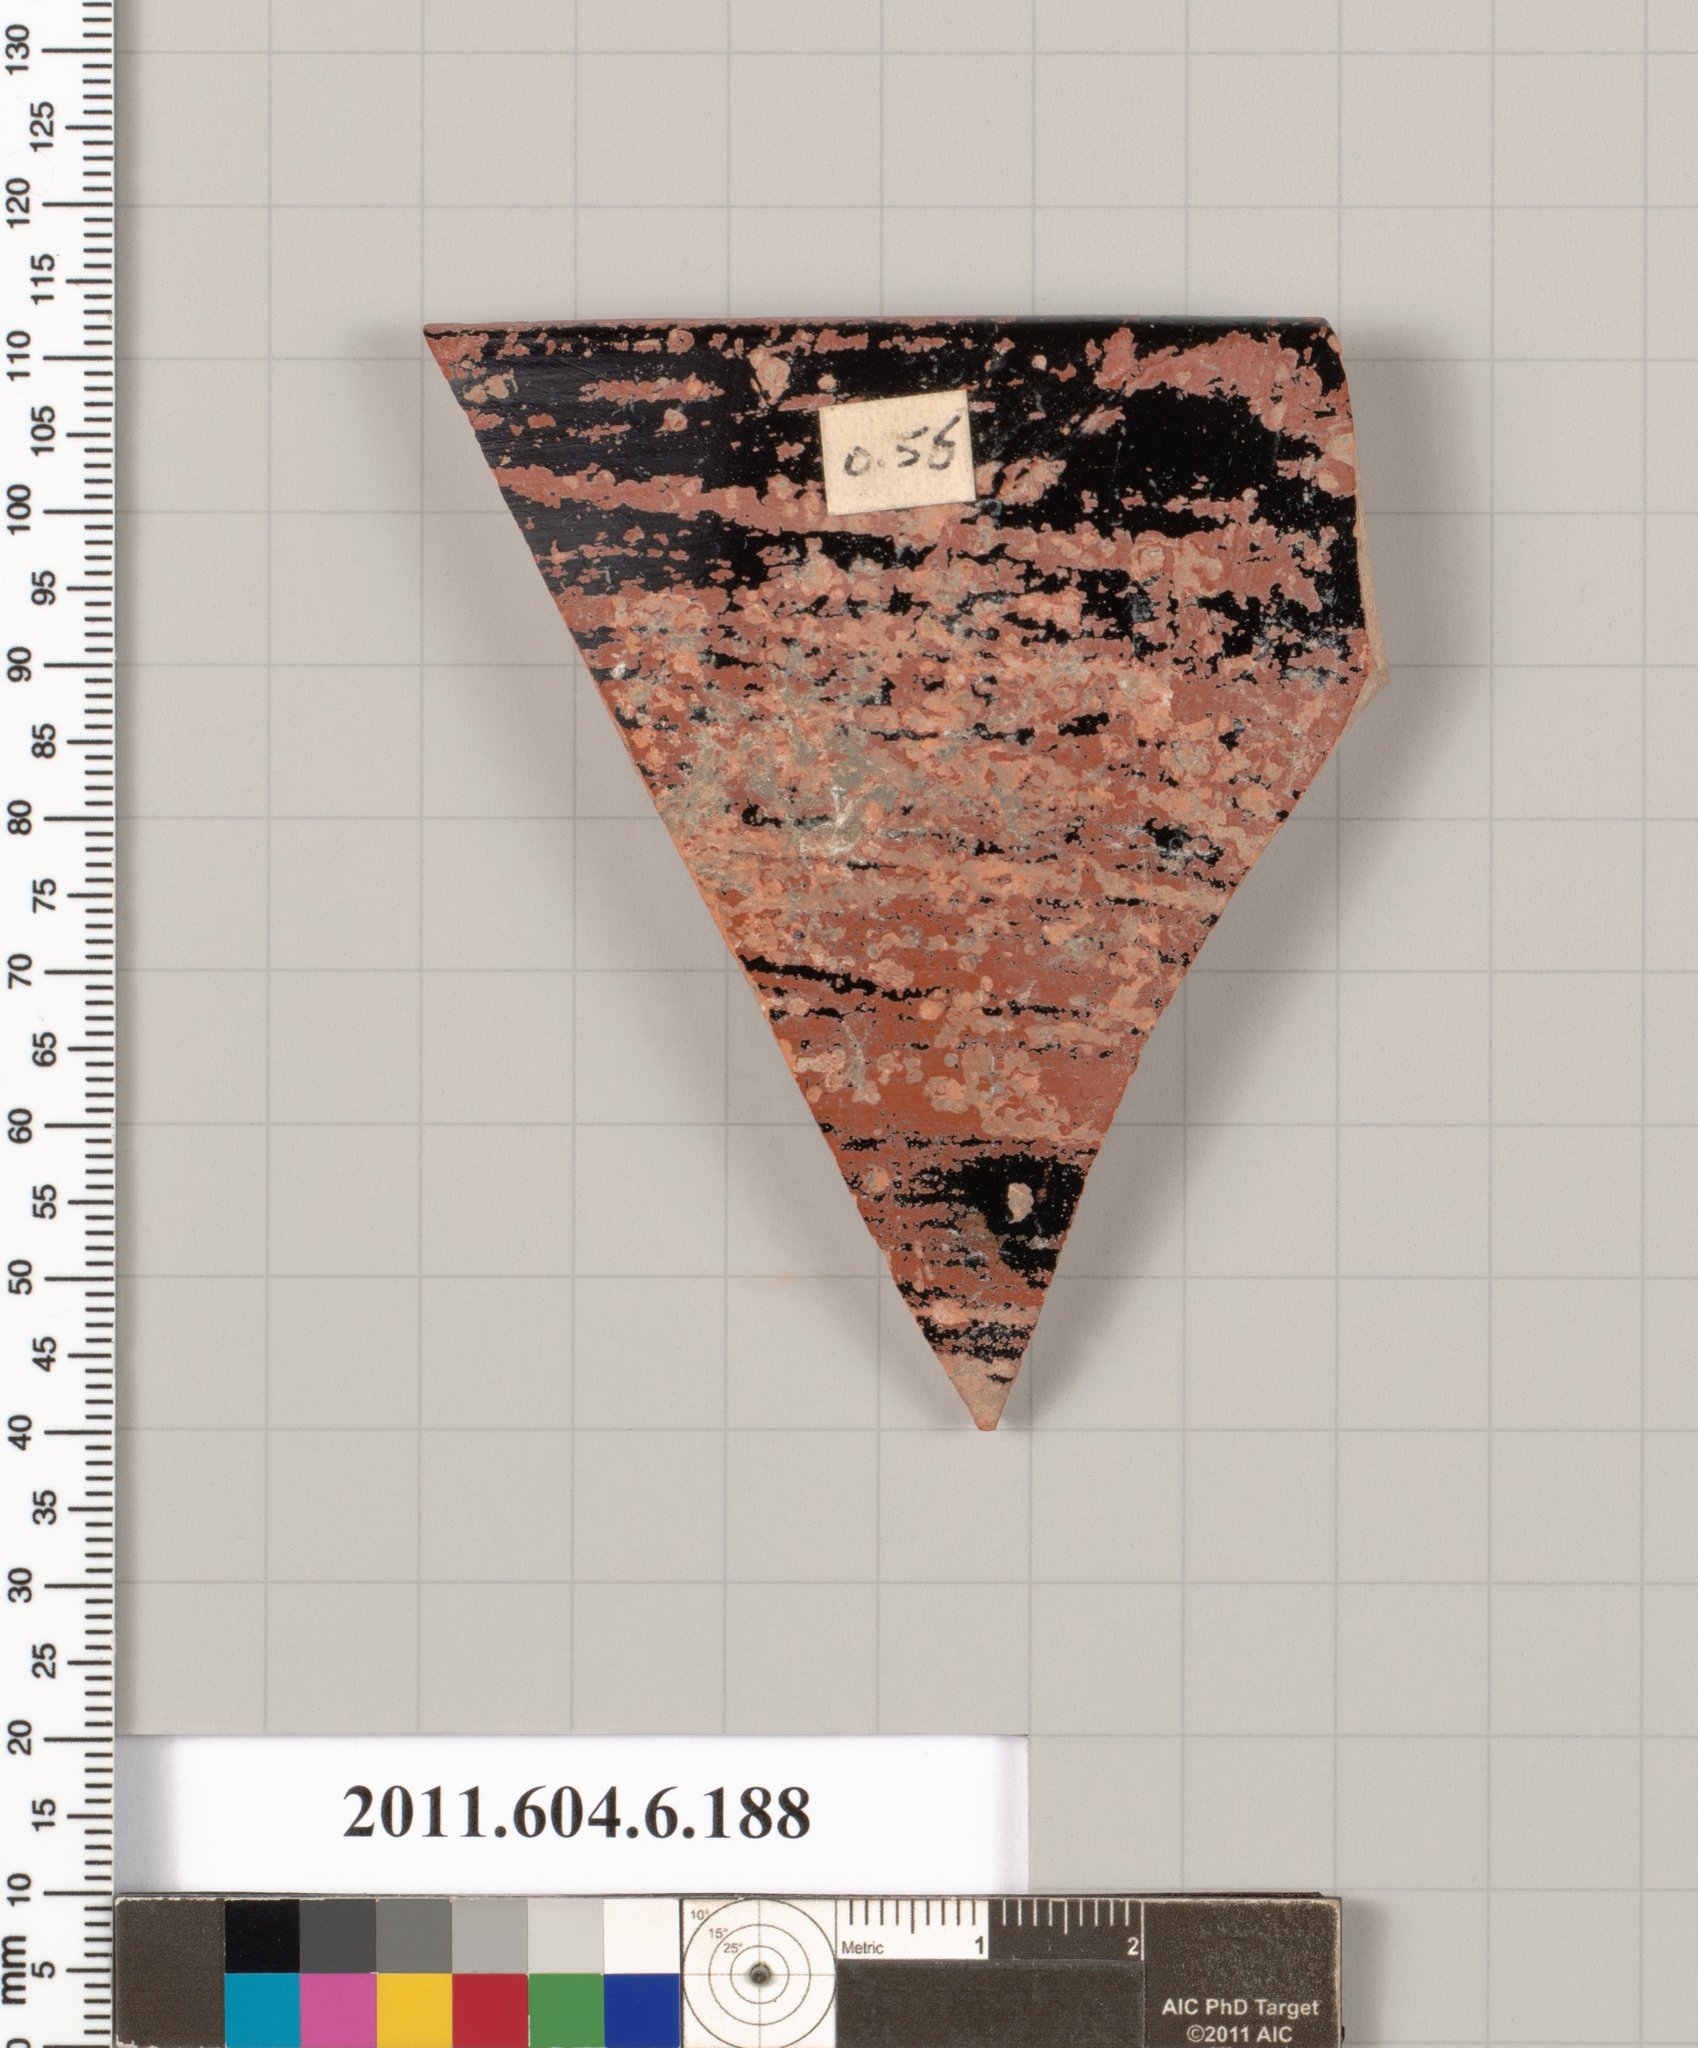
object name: skyphos fragment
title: Terracotta rim fragment of a skyphos (deep drinking cup)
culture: greek, attic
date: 500-401 BCE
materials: terracotta